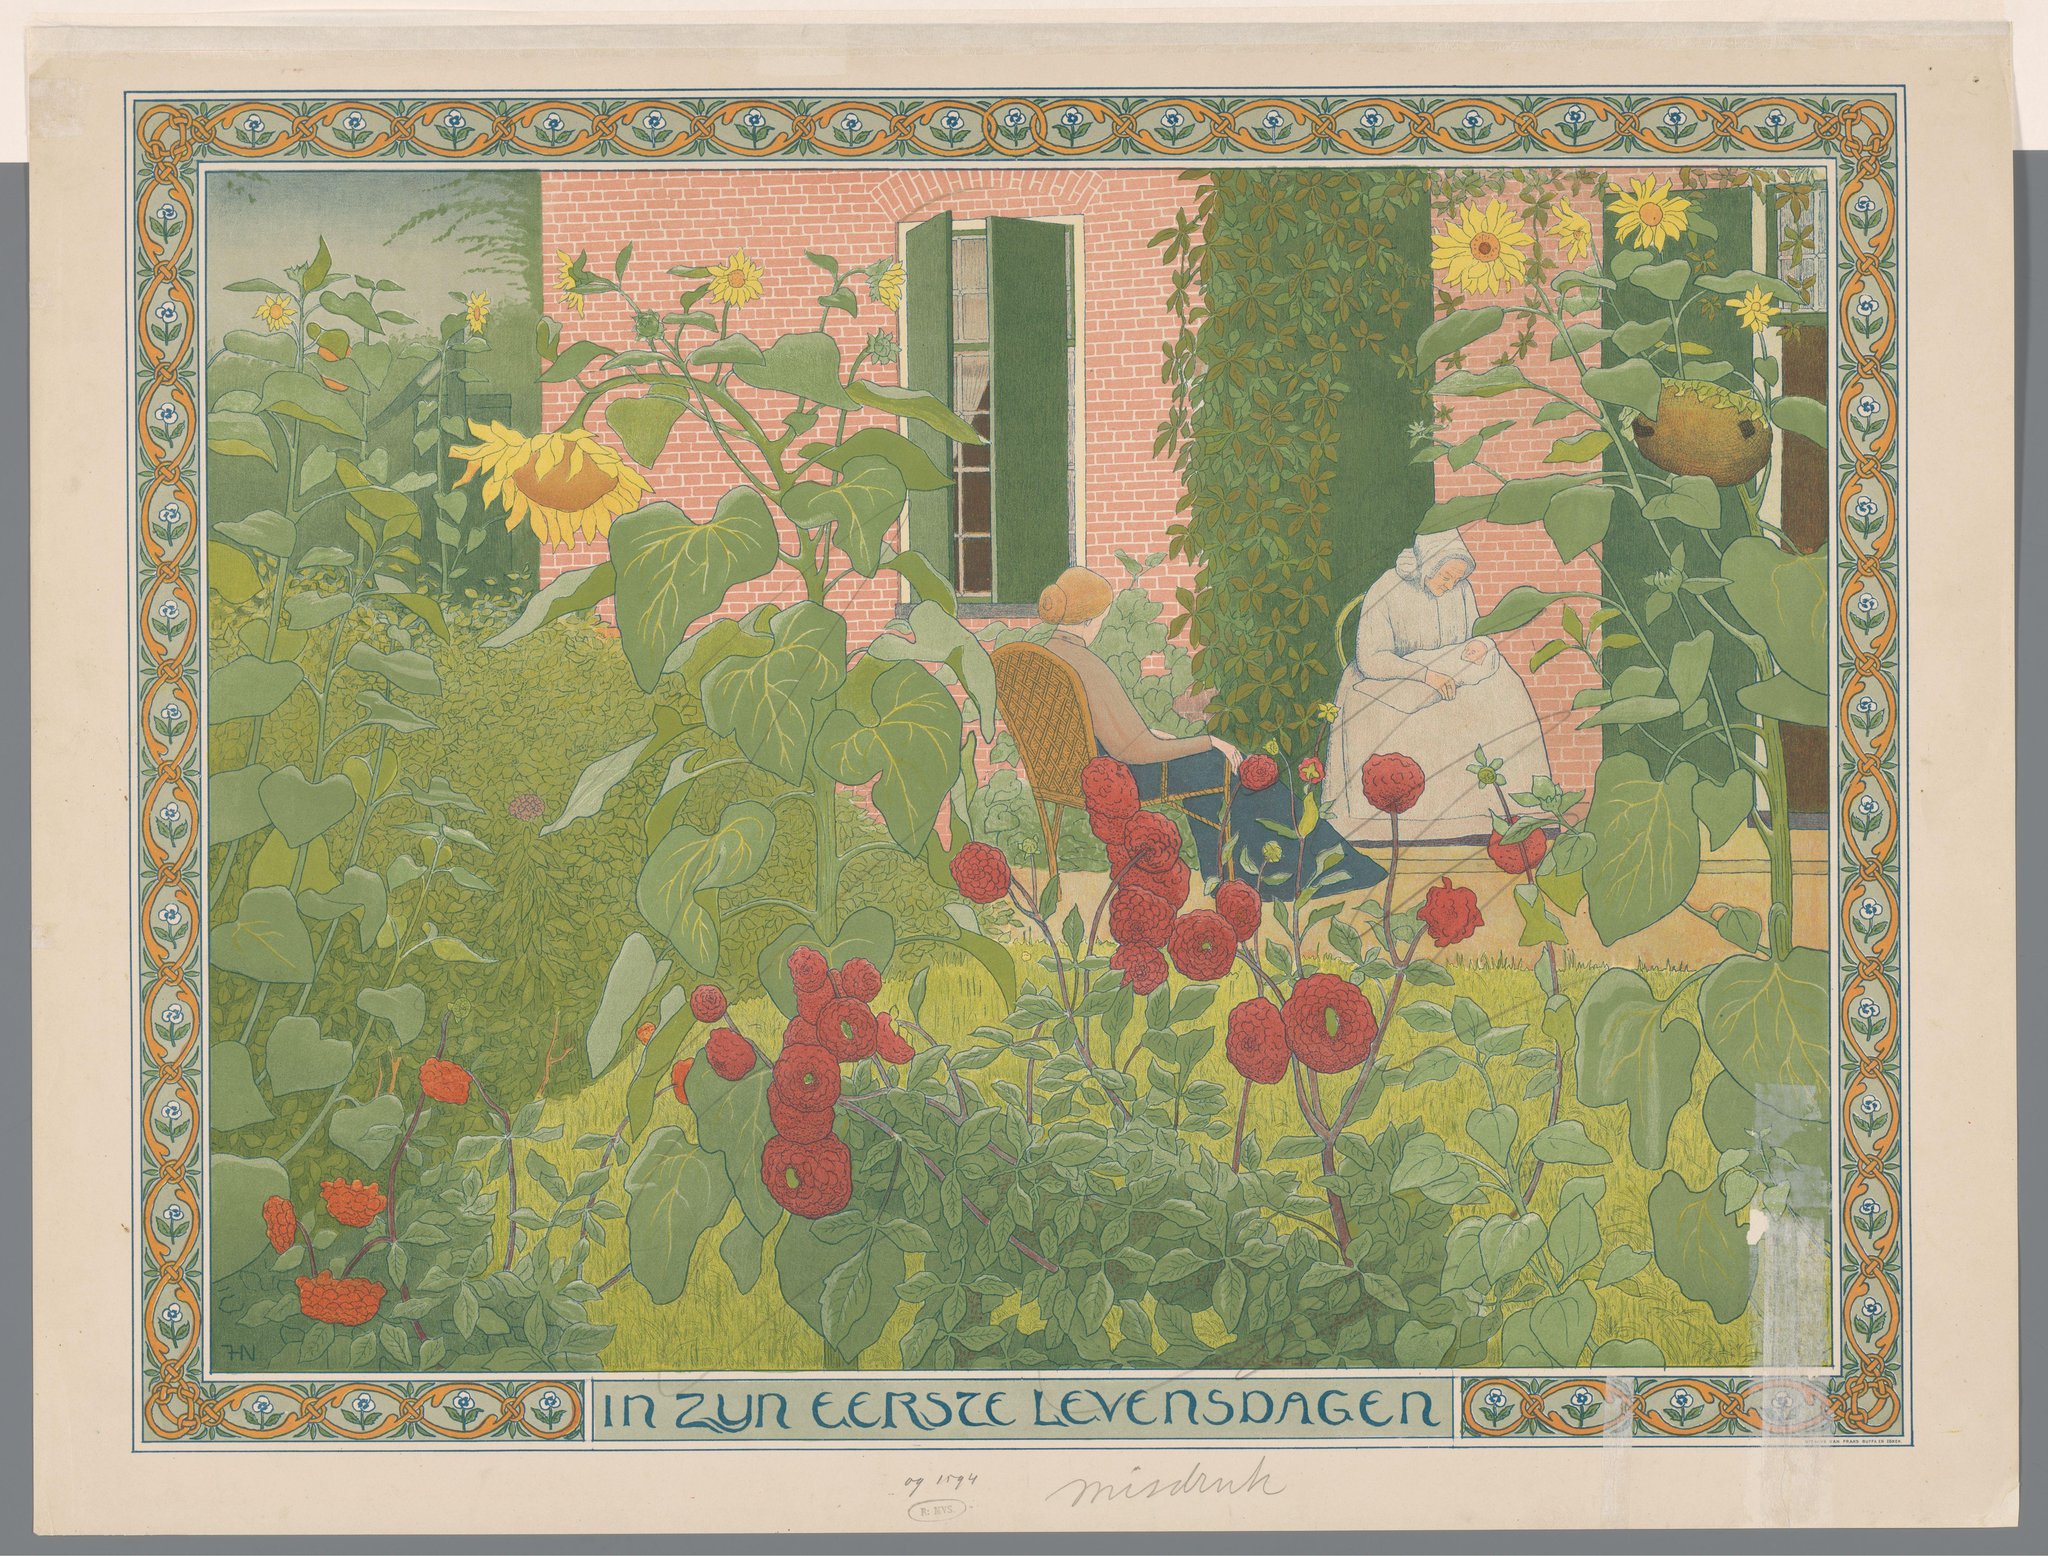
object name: print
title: Twee vrouwen met baby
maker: ferdinand hart nibbrig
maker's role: draughtsman, painter, print maker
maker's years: 1866-1915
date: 1876-1909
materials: paper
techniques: lithograph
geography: netherlands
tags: garden, hay-wagon, mother and child(ren), woman and child(ren) (family group)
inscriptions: inscription: ‘misdruk’, collector's mark: Lugt 2228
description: Tuin met veel bloemen en twee zittende vrouwen waarvan de rechter een baby in haar armen houdt. De voorstelling is met een paar potloodlijnen doorgekrast.